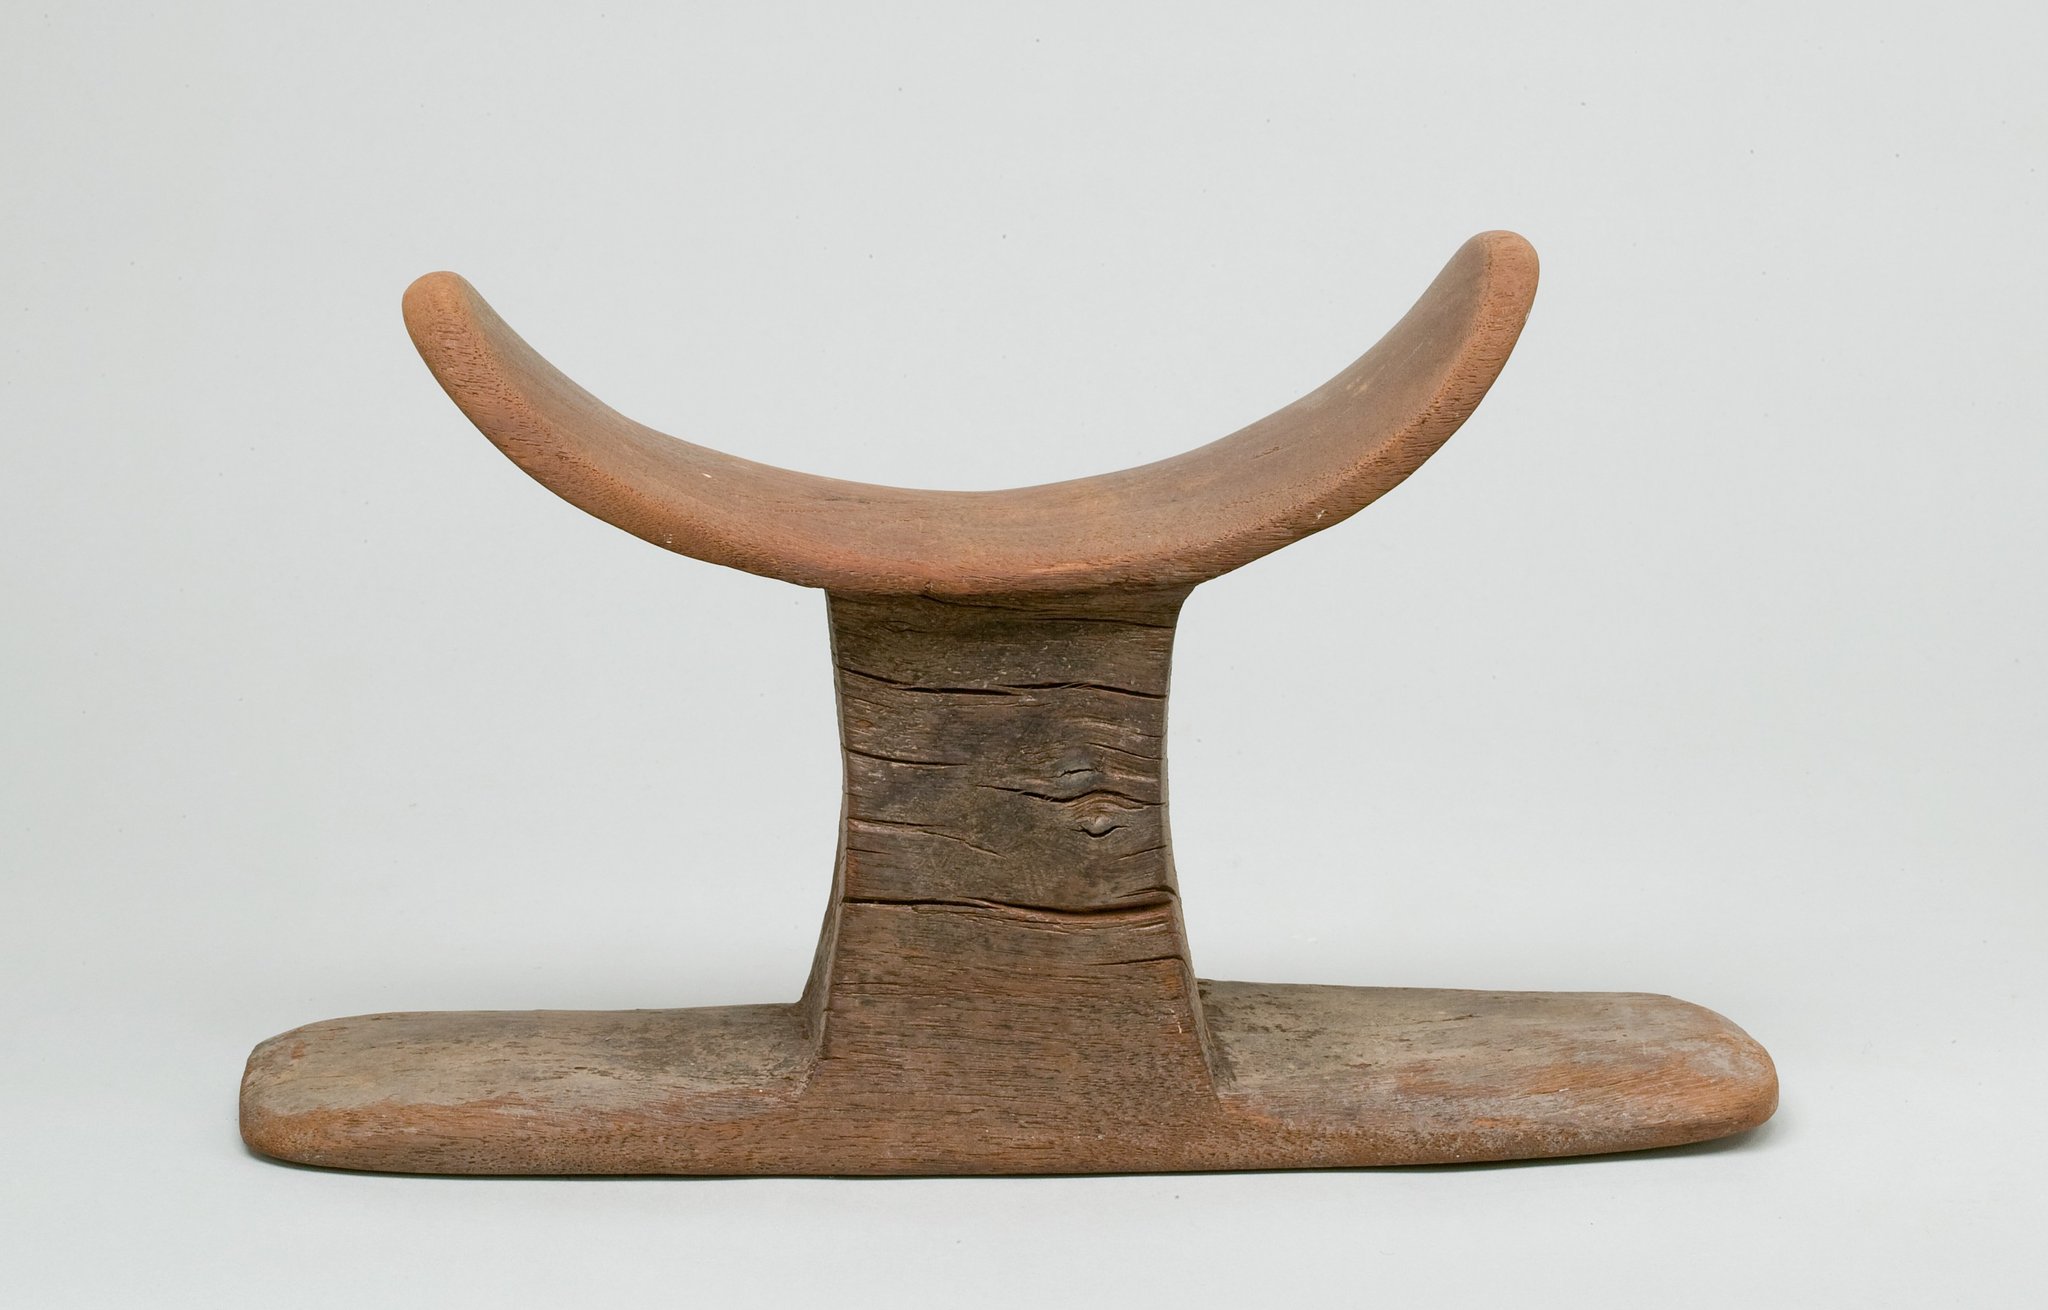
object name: headrest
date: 1550-1295 BCE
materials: wood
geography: egypt